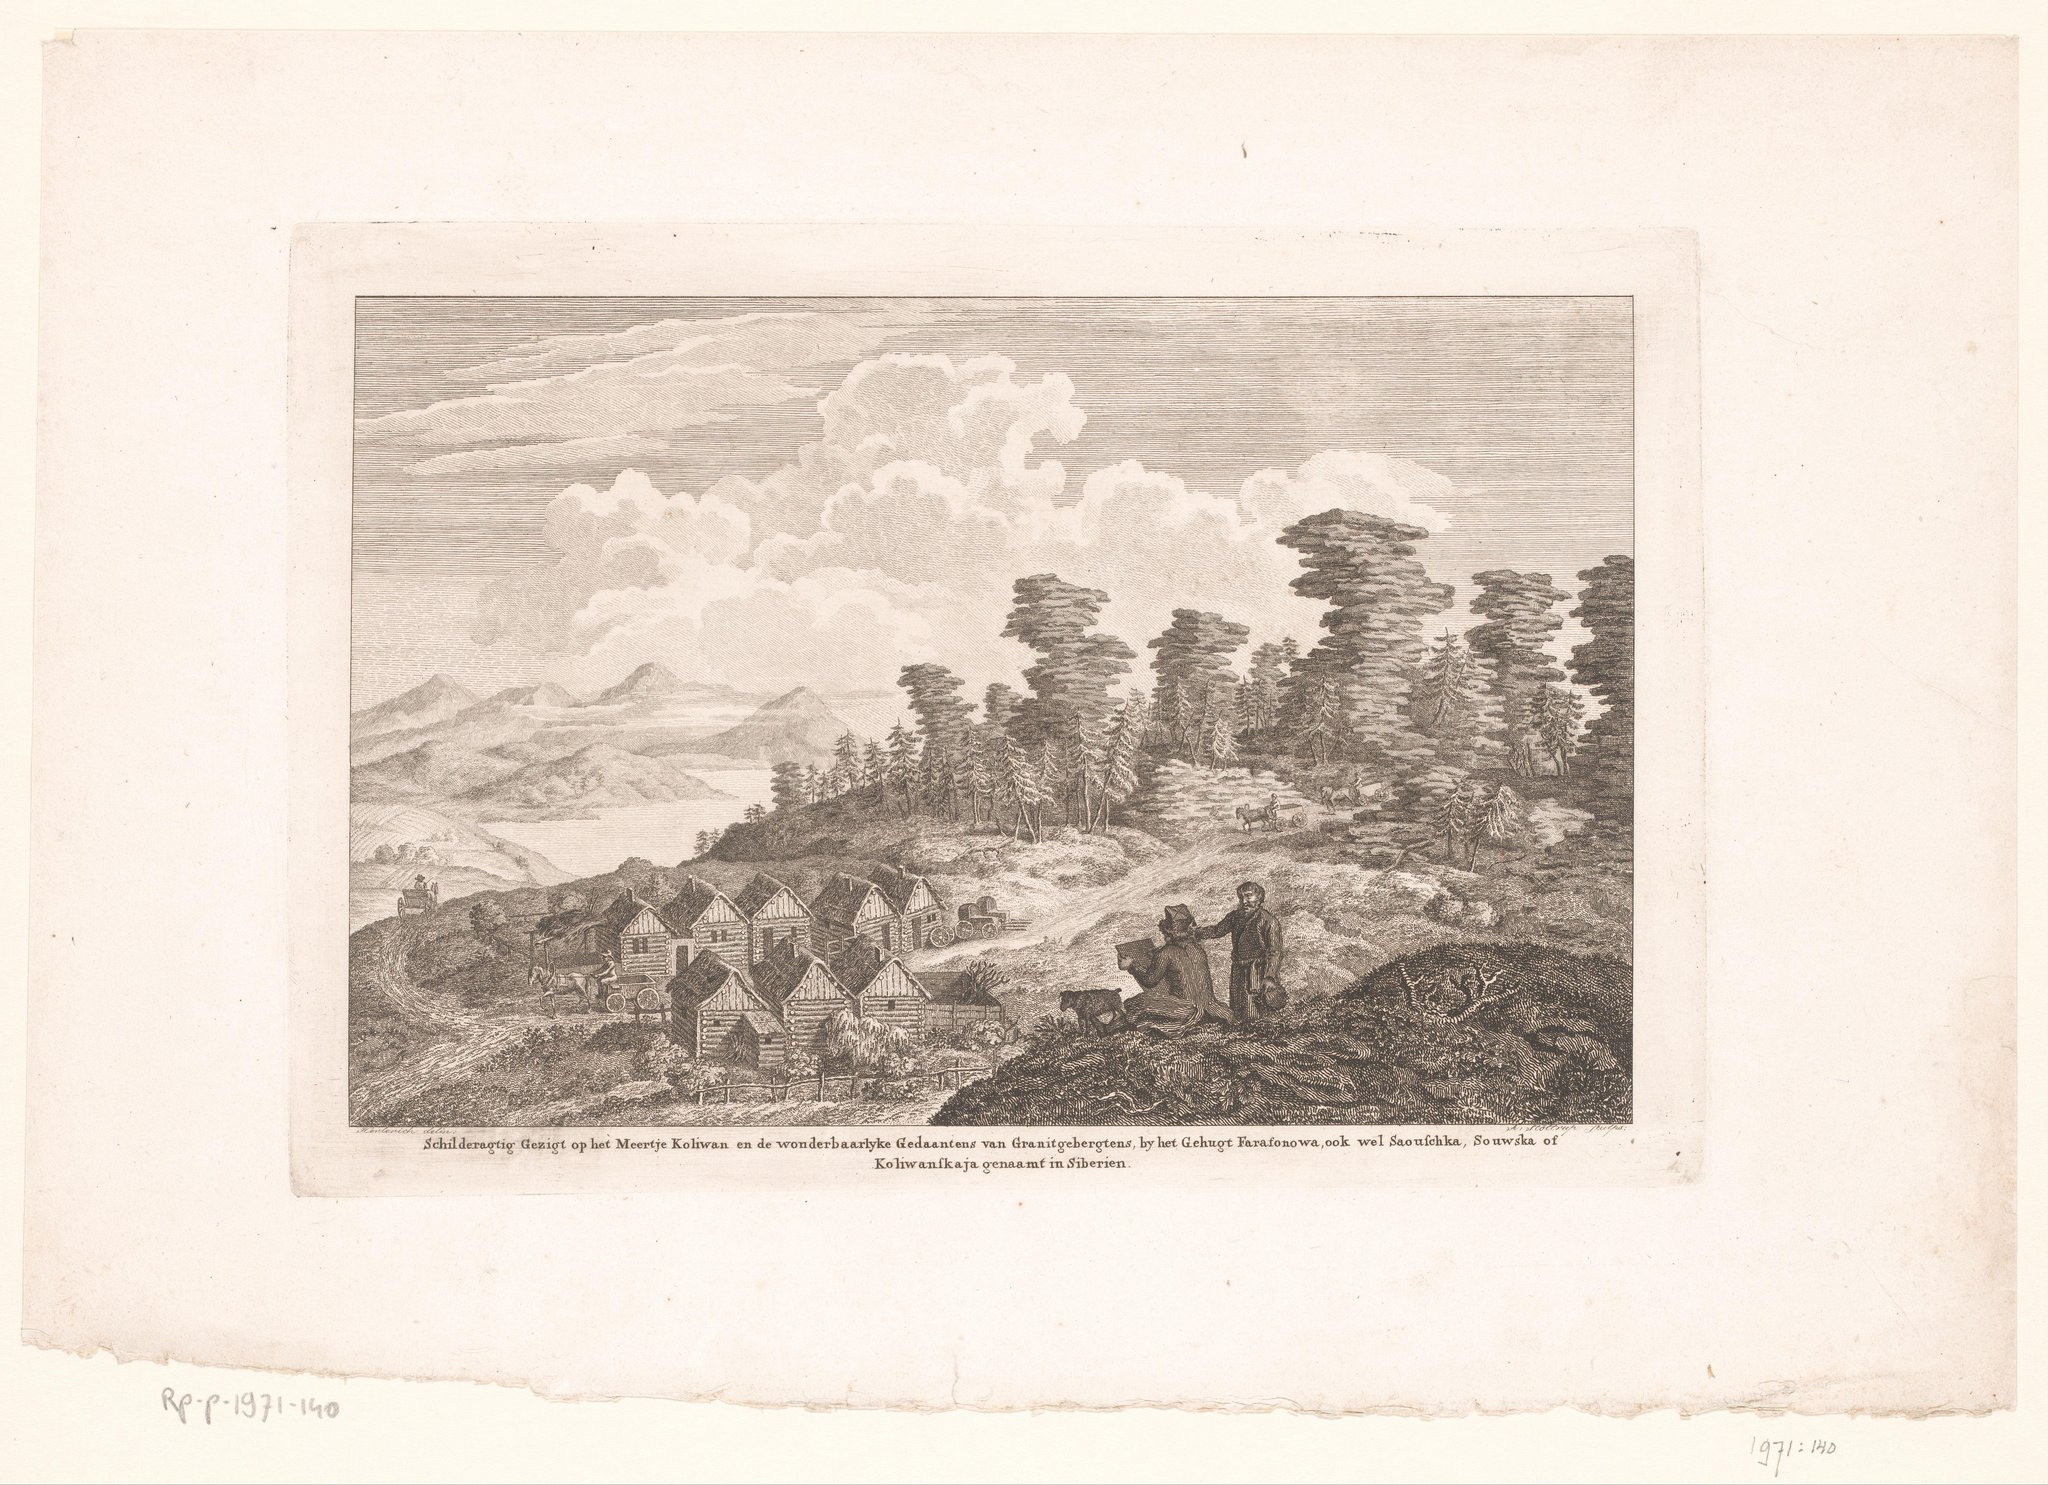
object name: print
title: Schilderagtig gezigt op het meertje Koliwan en de wonderbaarlyke (...)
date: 1782-1811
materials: paper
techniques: etching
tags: lake, forest, wood, mountains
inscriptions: collector's mark: Lugt 2760, collector's mark: Lugt 2228